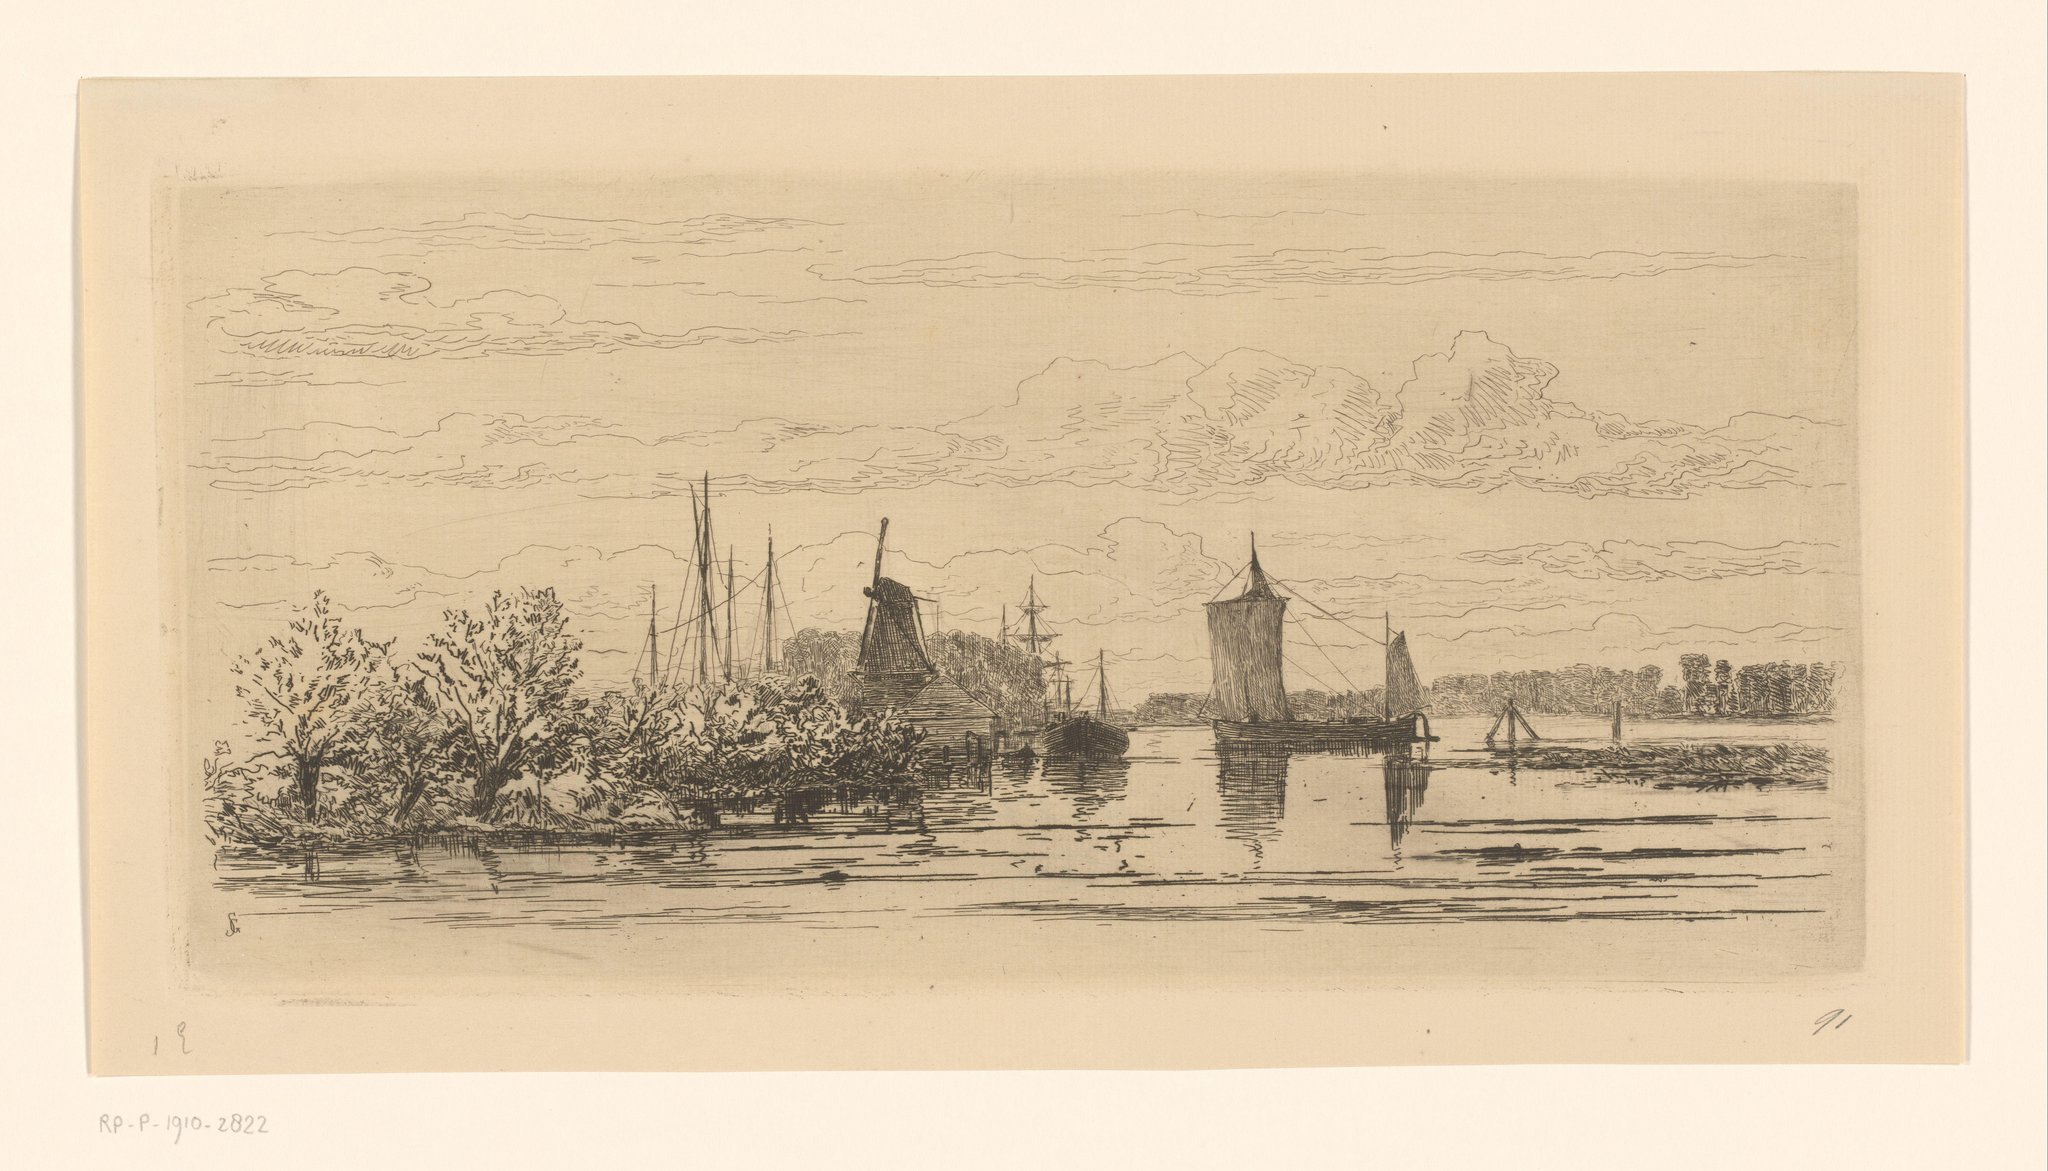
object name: print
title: La Hollande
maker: carel nicolaas storm van s-gravesande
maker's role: draughtsman, print maker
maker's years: 1841-1924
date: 1877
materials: paper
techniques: etching, intaglio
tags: sailing-ship, sailing-boat, windmill in landscape, dordrecht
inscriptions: collector's mark: Lugt 2228